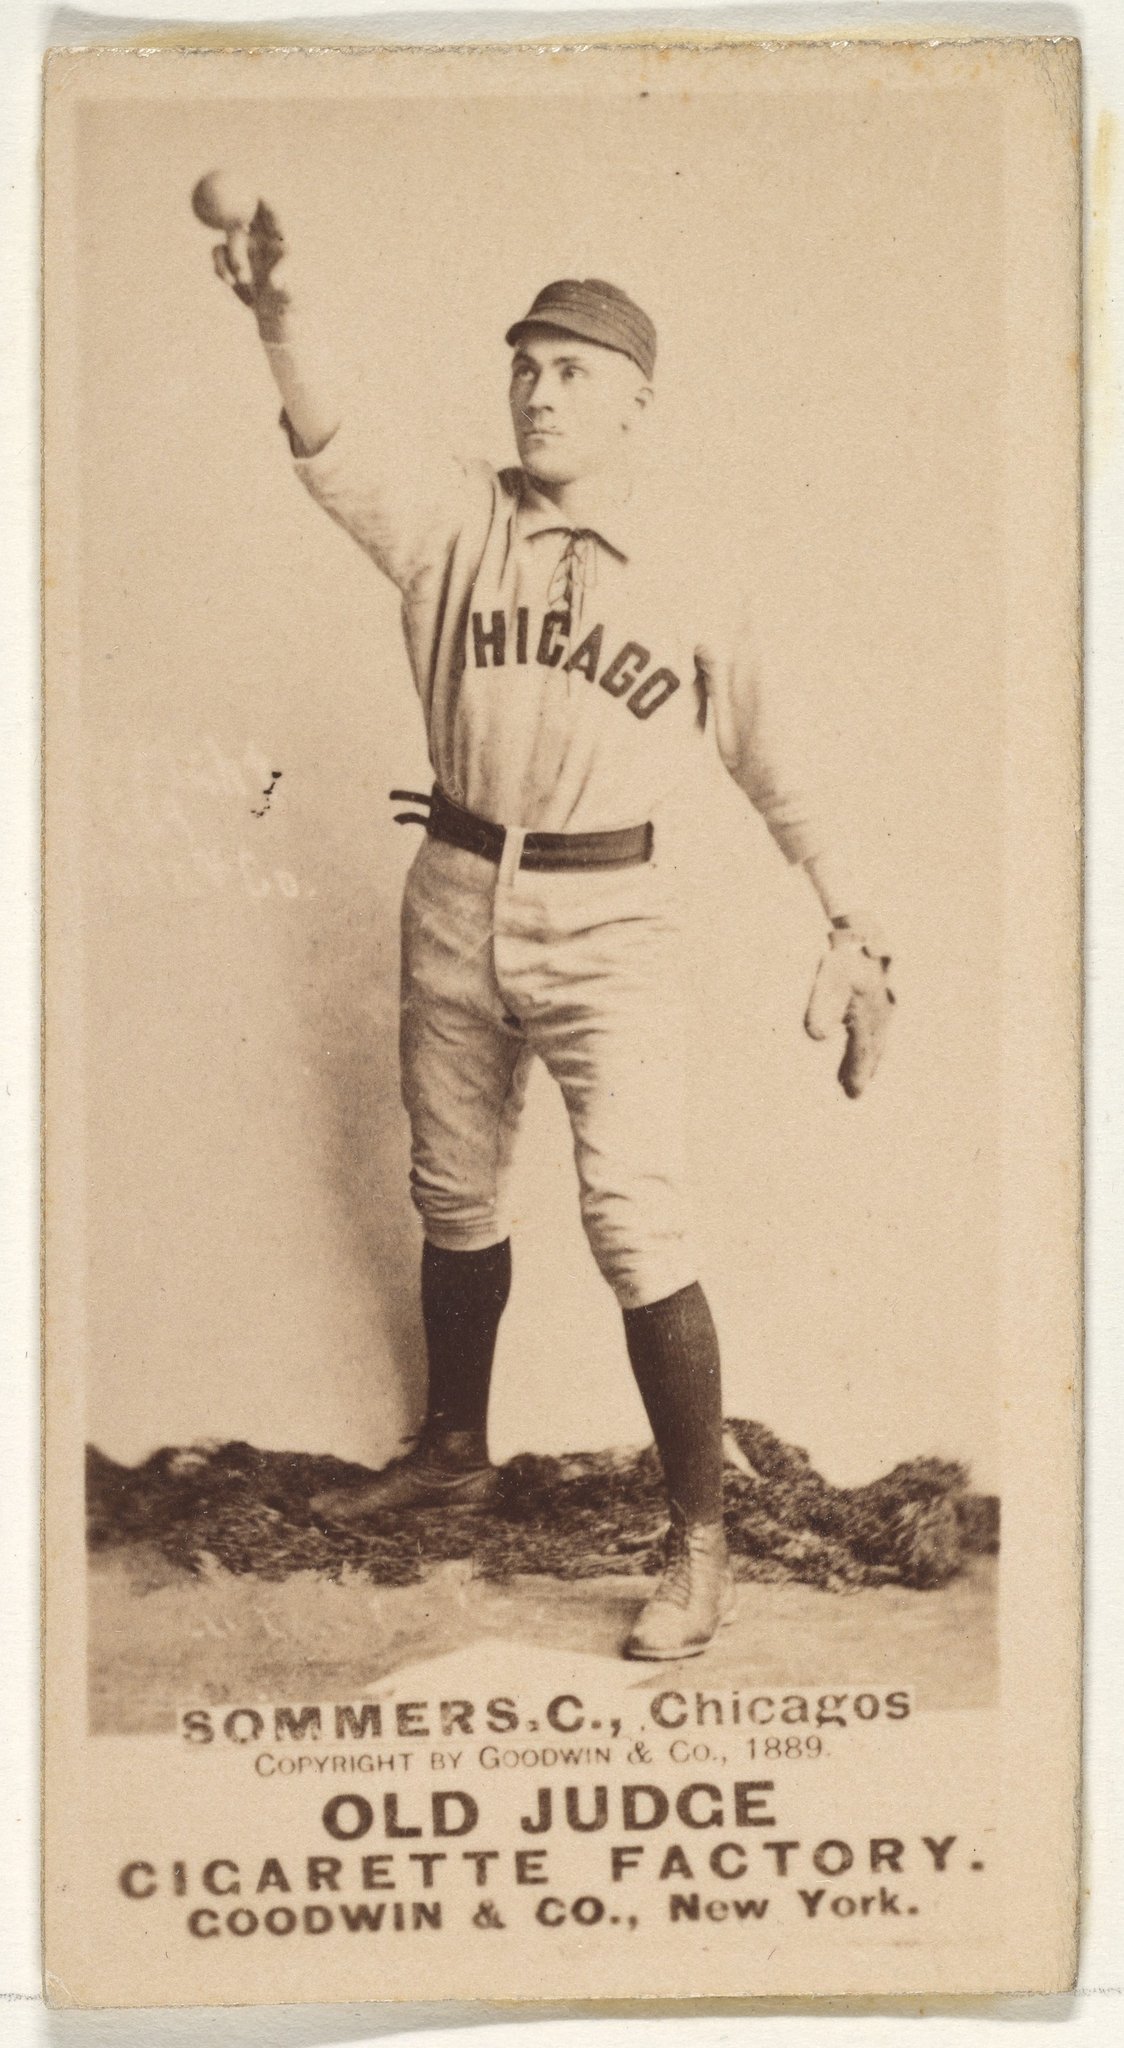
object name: baseball card, photograph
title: Sommers, Catcher, Chicago, from the Old Judge series (N172) for Old Judge Cigarettes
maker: goodwin & company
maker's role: publisher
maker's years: 1850-1950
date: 1889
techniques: albumen silver print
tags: men,portraits,baseball,athletes